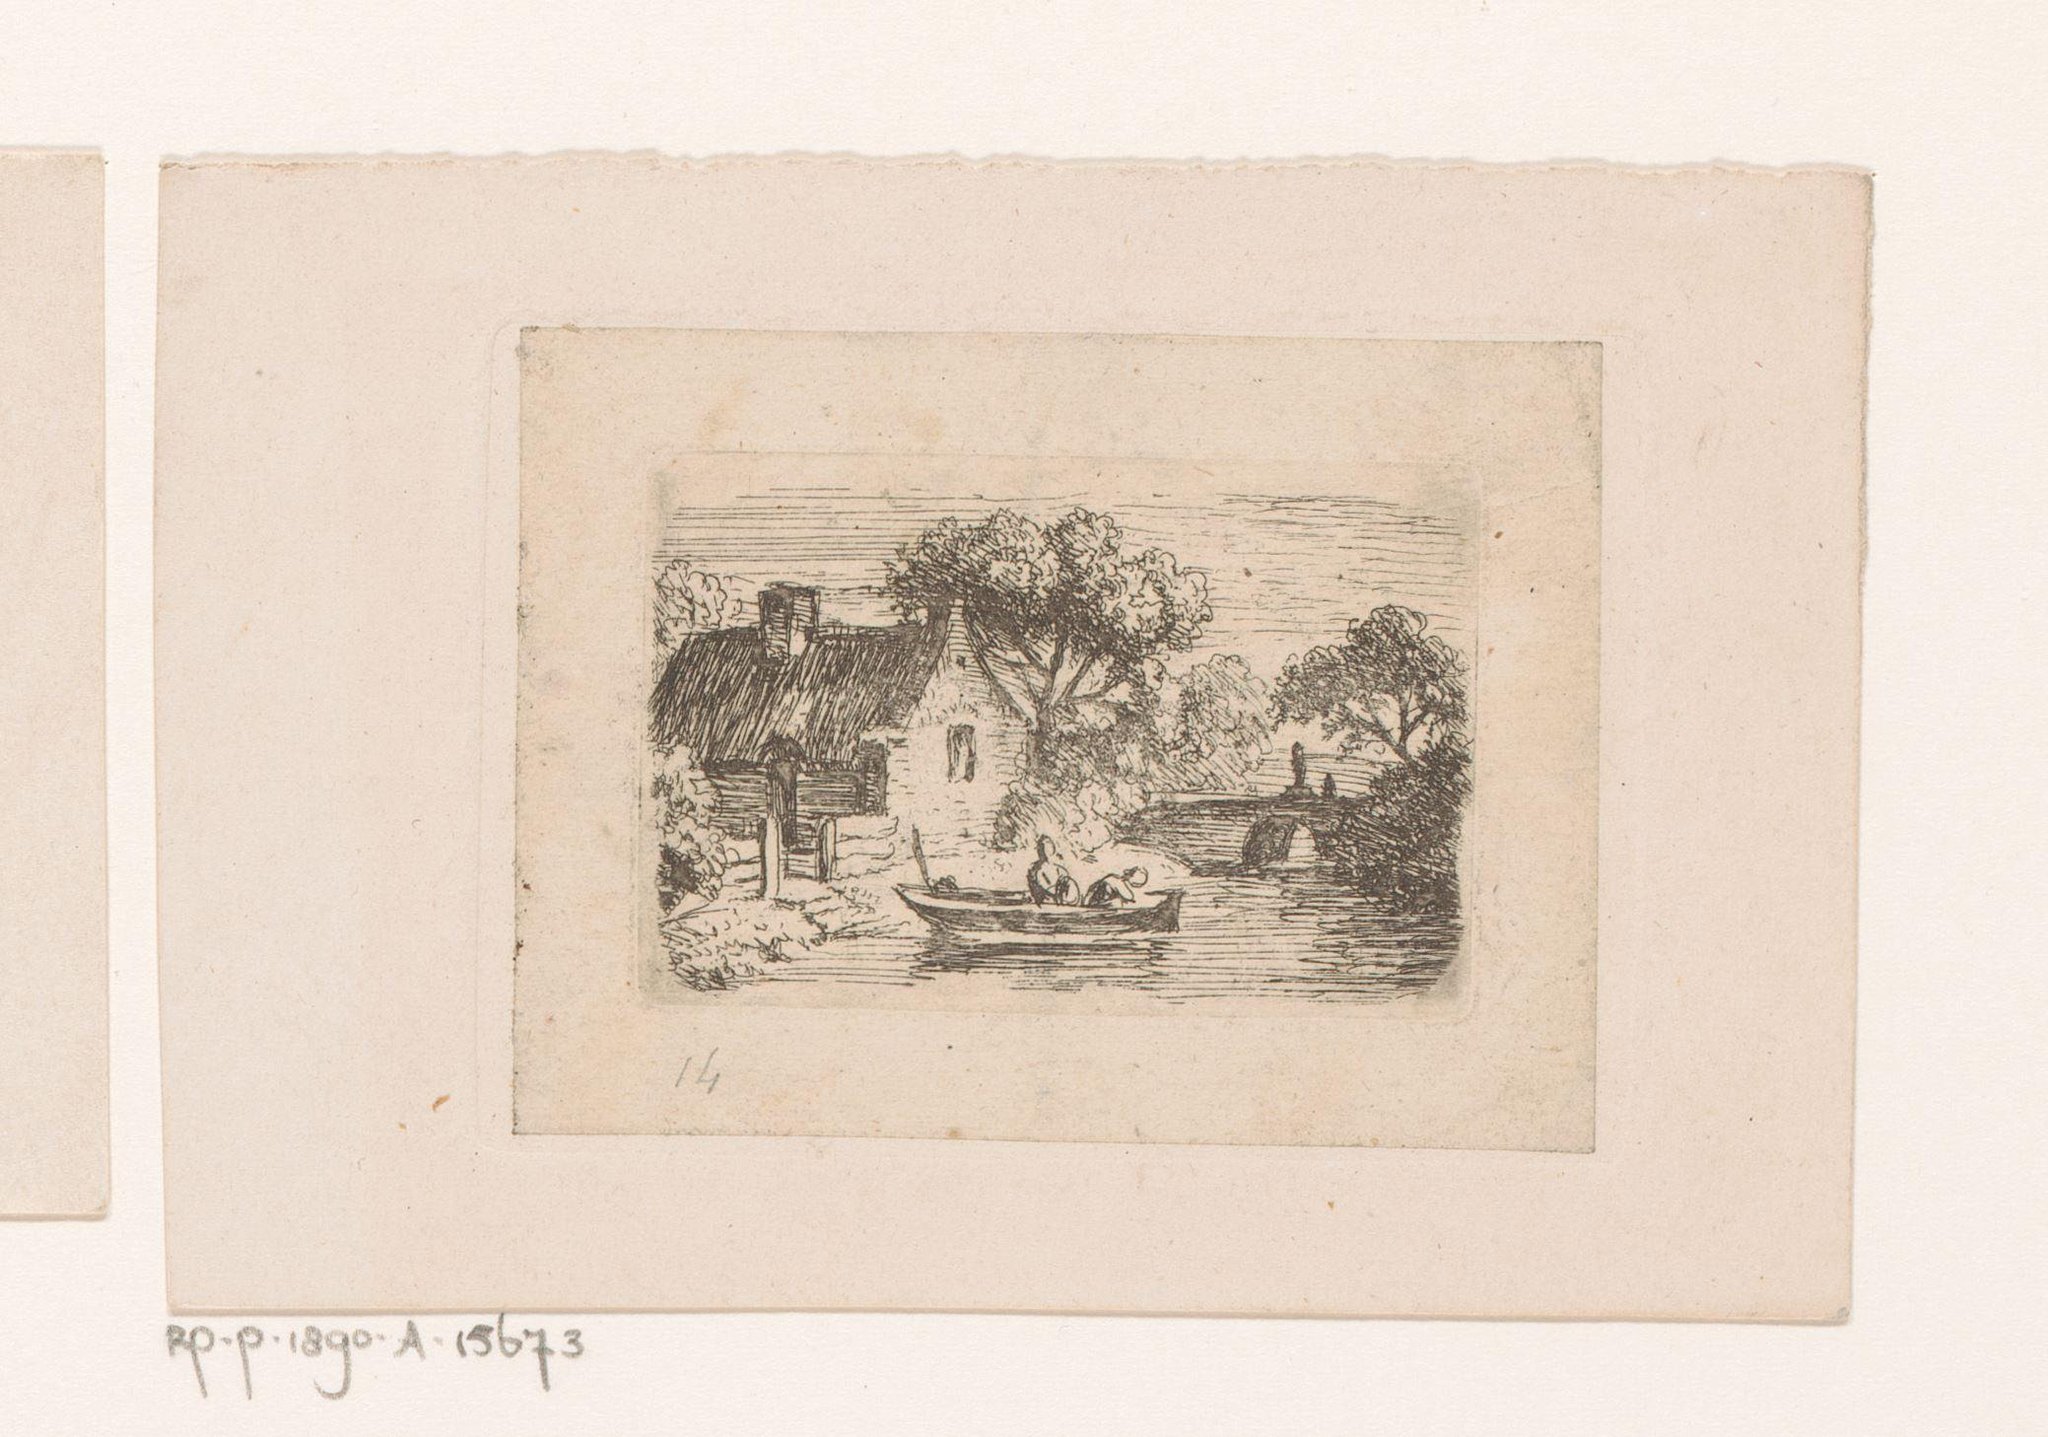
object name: print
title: Landschap met twee personen in een roeiboot bij een woning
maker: hendrik jozef franciscus van der poorten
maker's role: draughtsman, print maker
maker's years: 1789-1874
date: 1799-1874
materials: paper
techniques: etching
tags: rowing-boat, canoe, etc., bridge in village across river, canal, etc.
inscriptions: collector's mark: Lugt 2228